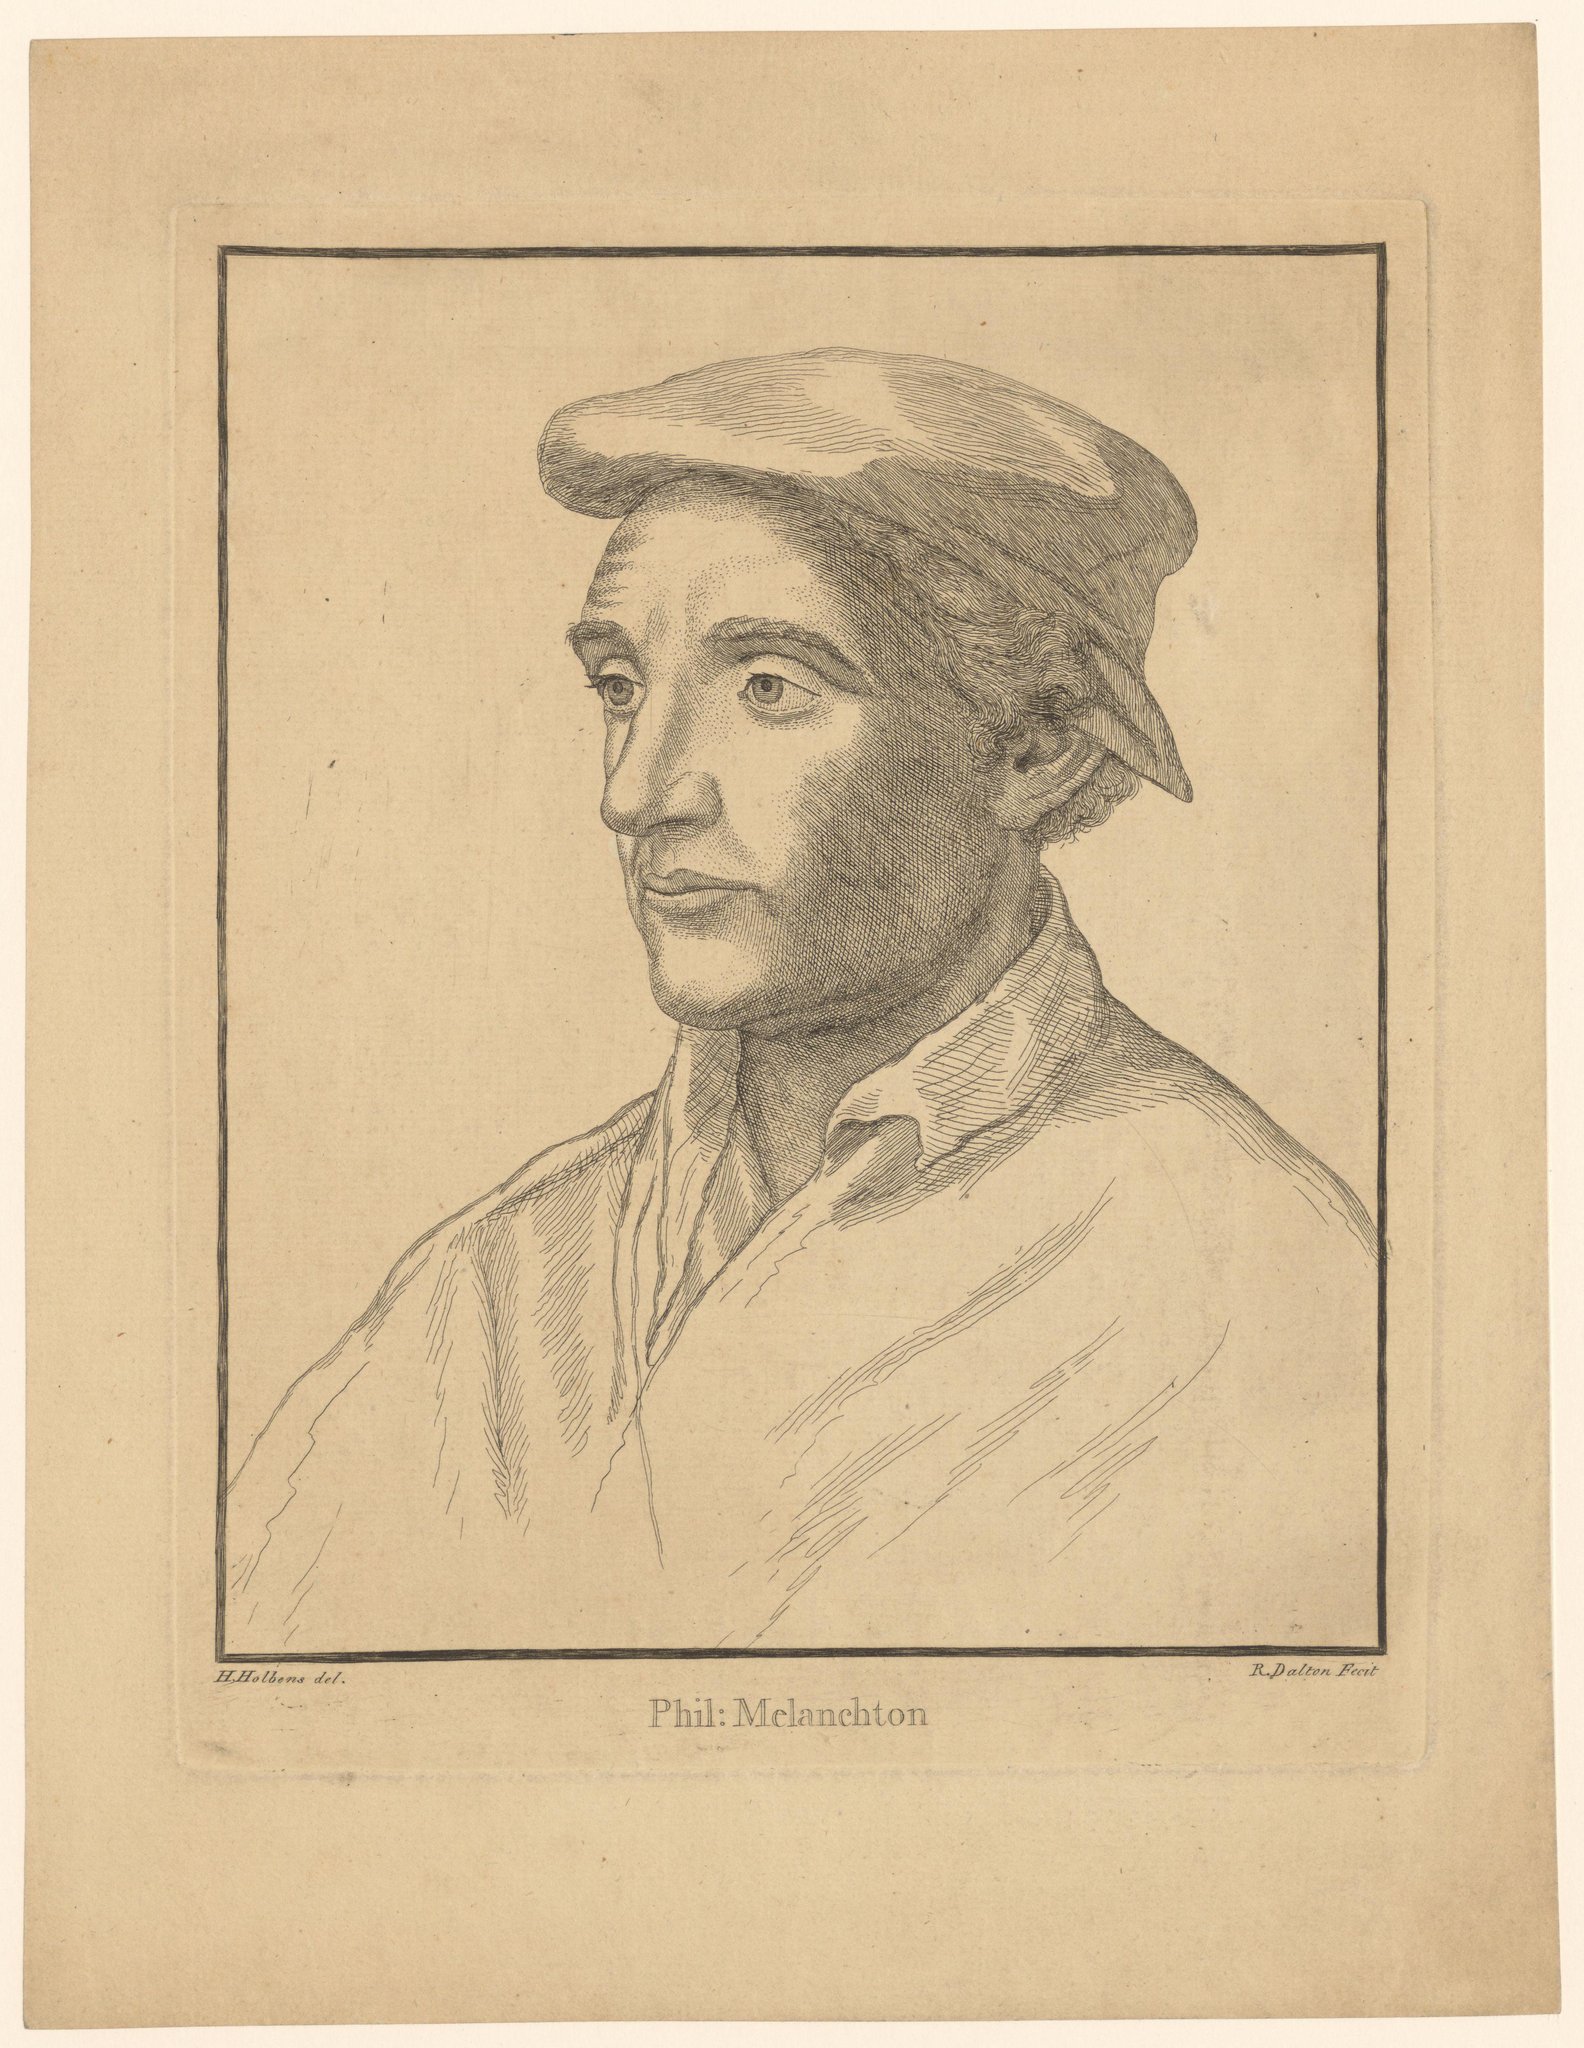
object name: print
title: Portret van Philipp Melanchthon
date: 1725-1791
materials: paper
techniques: etching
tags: historical persons, scholar, philosopher (+ portrait of scholar, scientist)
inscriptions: collector's mark: Lugt 2233